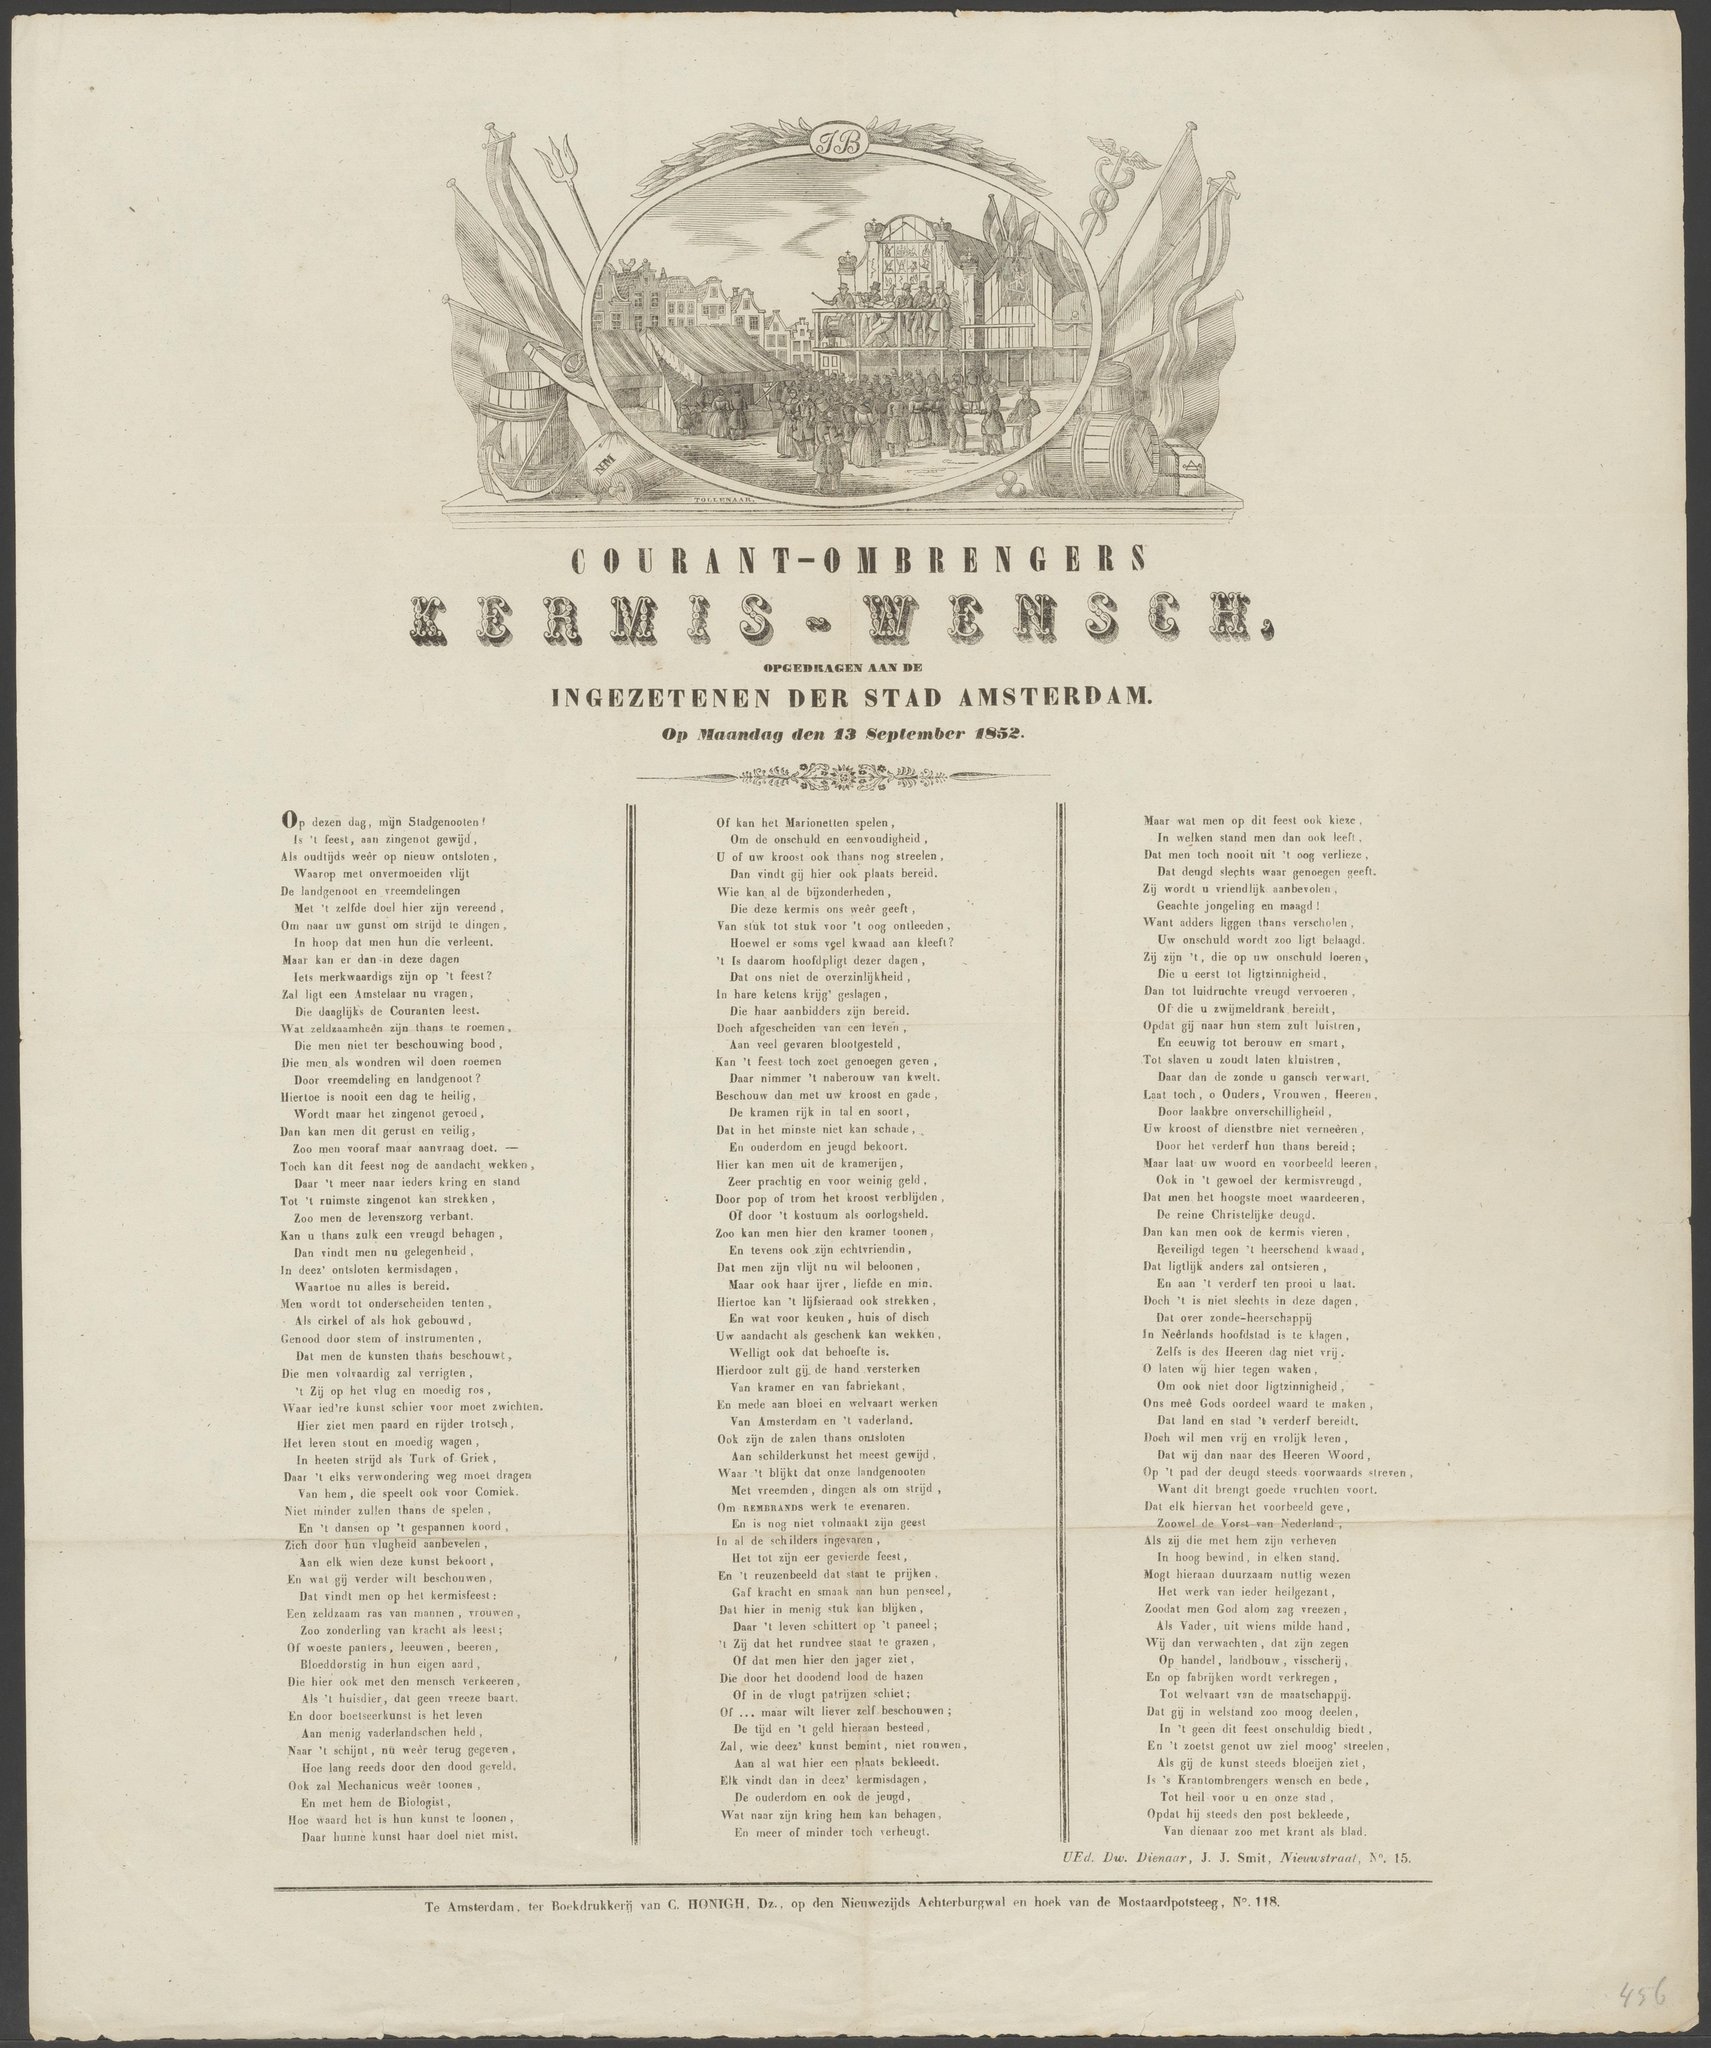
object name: print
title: Courant-ombrengers Kermis-wensch, opgedragen aan de ingezetenen der stad Amsterdam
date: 1851-1852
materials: paper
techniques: letterpress printing, engraving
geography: amsterdam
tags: public festivities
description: Kermisprent namens de ombrengers van couranten (krantenbezorgers) te Amsterdam, 13 september 1852. Bovenaan een medaillon met een gezicht op de kermis op de Botermarkt. Onderaan een gedicht in drie kolommen. Van de courantombrenger: J.J. Smit. Onderwerpsrubrieken binnen de Atlas Zeden en Gewoonten: Zeden en gewoonten in engeren zin, Volksleven, Volksbladen, Nieuwjaars- en Kerstwenschen, Amsterdam.